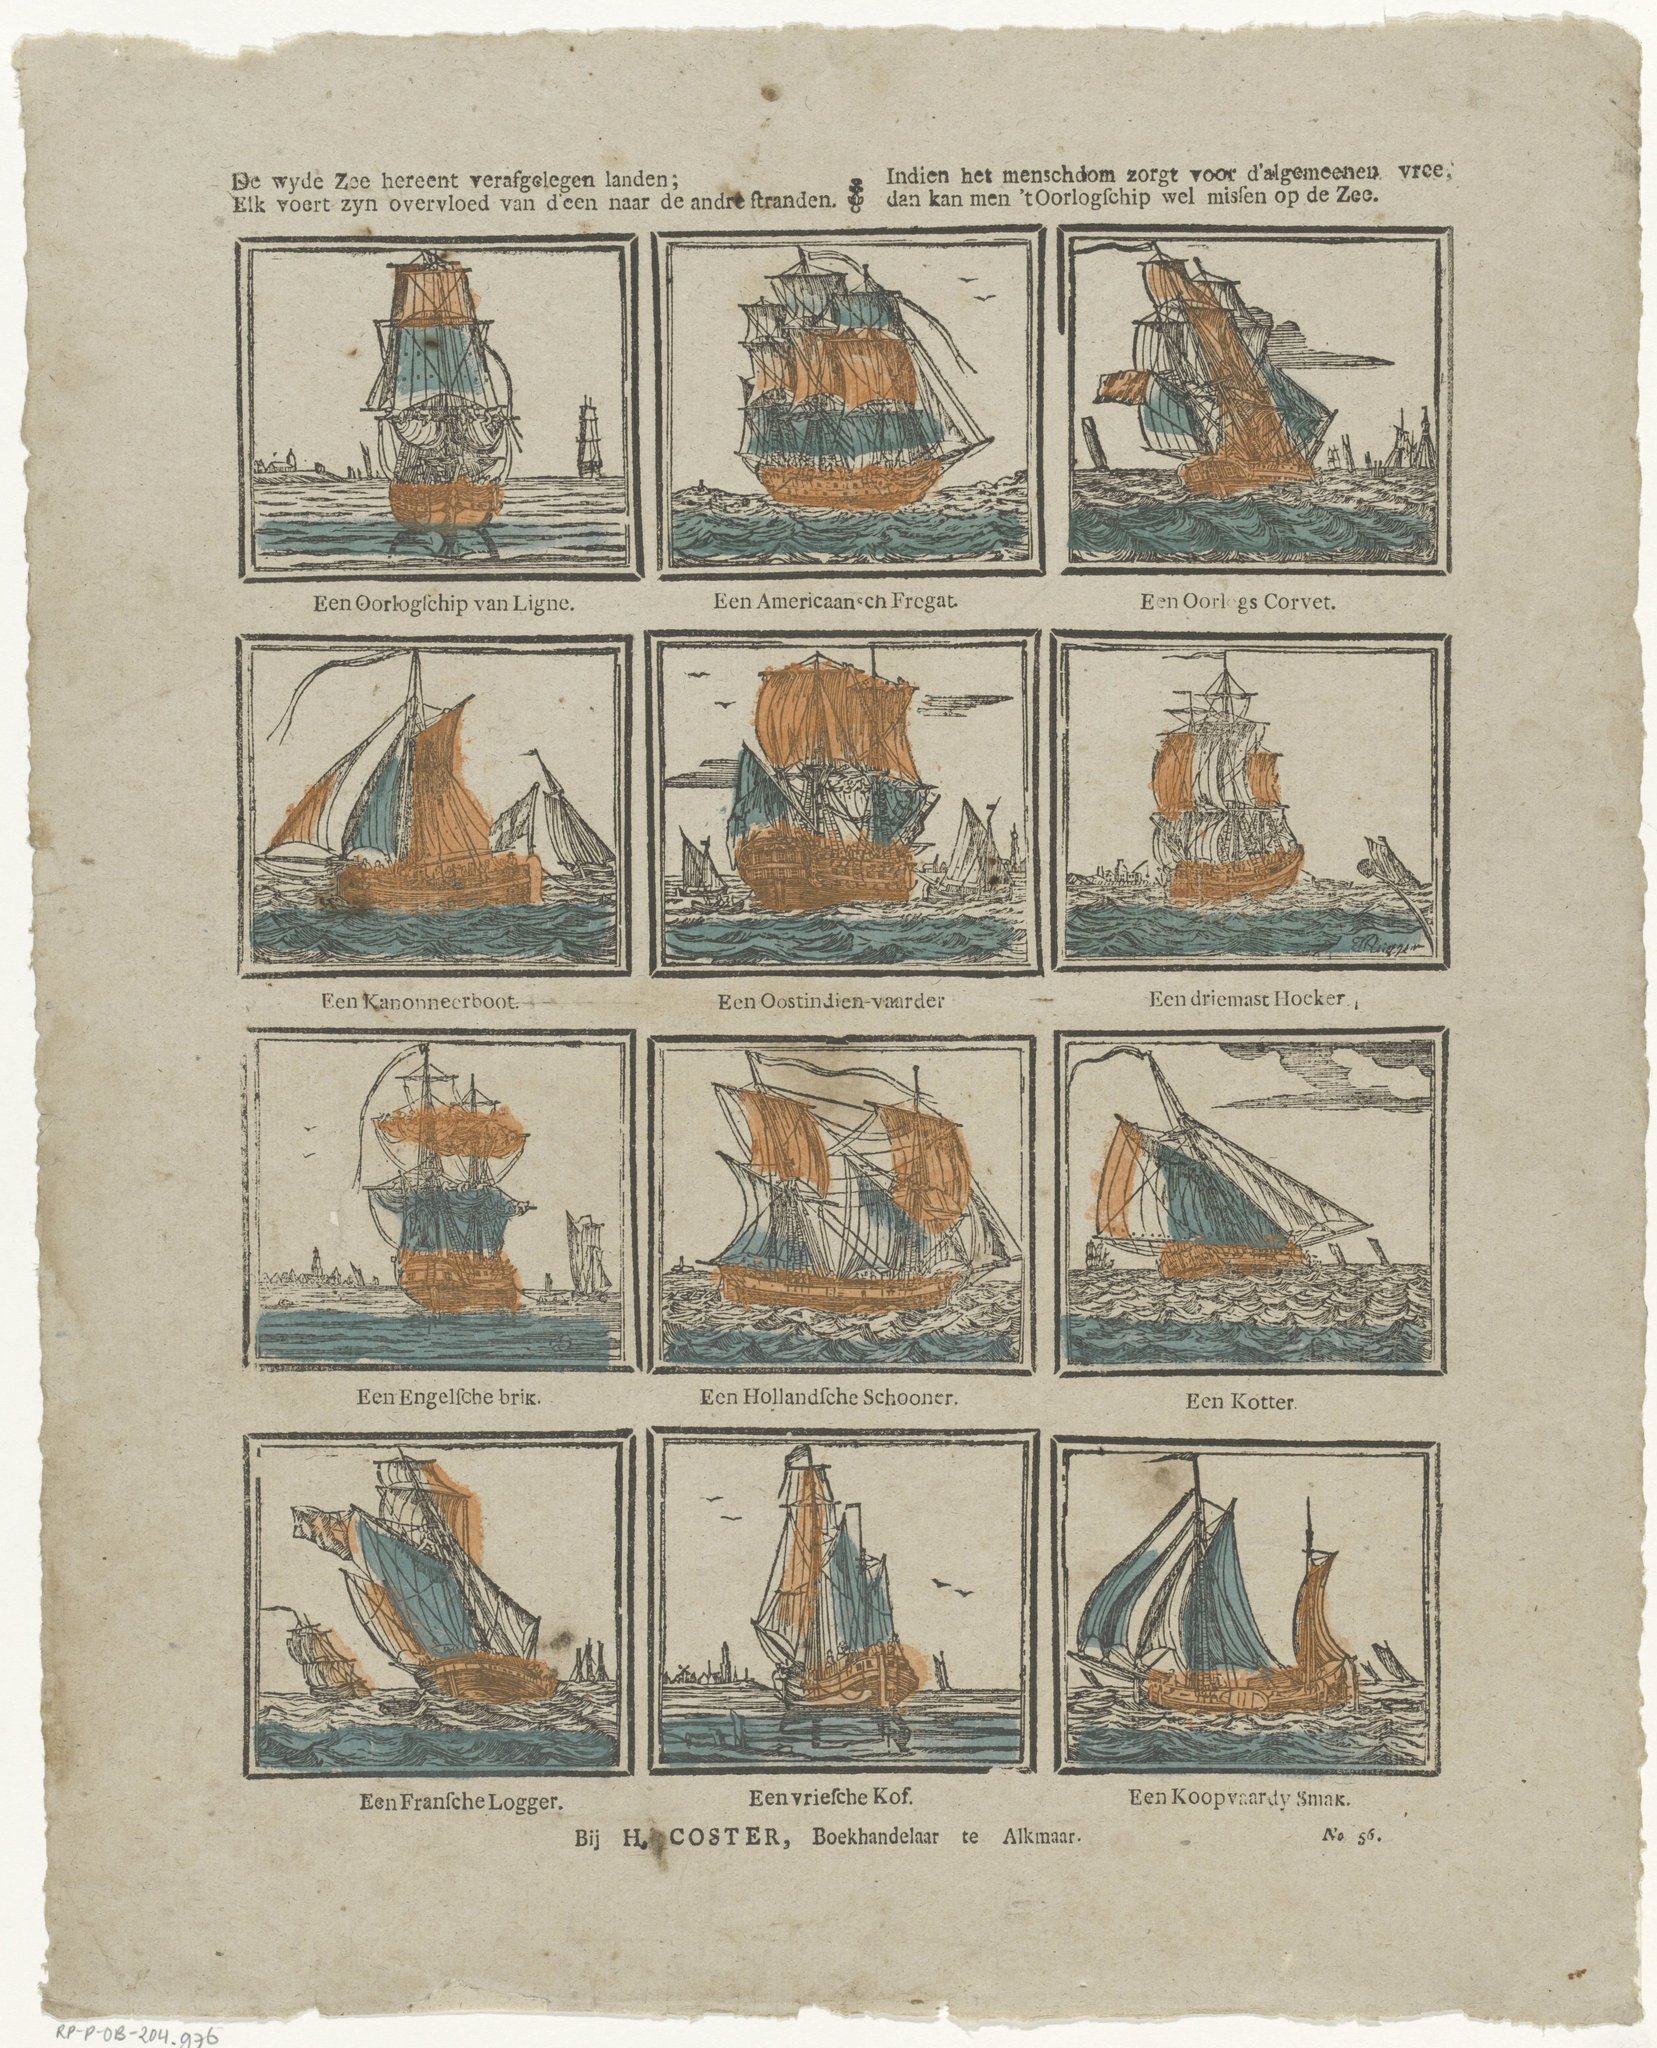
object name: print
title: De wyde zee hereent verafgelegen landen; / Elk voert zyn overvloed van d'een naar de andre stranden. / Indien het menschdom zorgt voor d'algemeenen vree, / dan kan men 't oorlogsschip wel missen op de zee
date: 1806-1830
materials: paper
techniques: colour, letterpress printing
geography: zaltbommel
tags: military vehicles (+ sailing-ships), ships (in general)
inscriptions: collector's mark: Lugt 2760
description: Blad met 12 voorstellingen van zeilschepen. Onder elke afbeelding een onderschrift. Genummerd rechtsonder: No. 56.